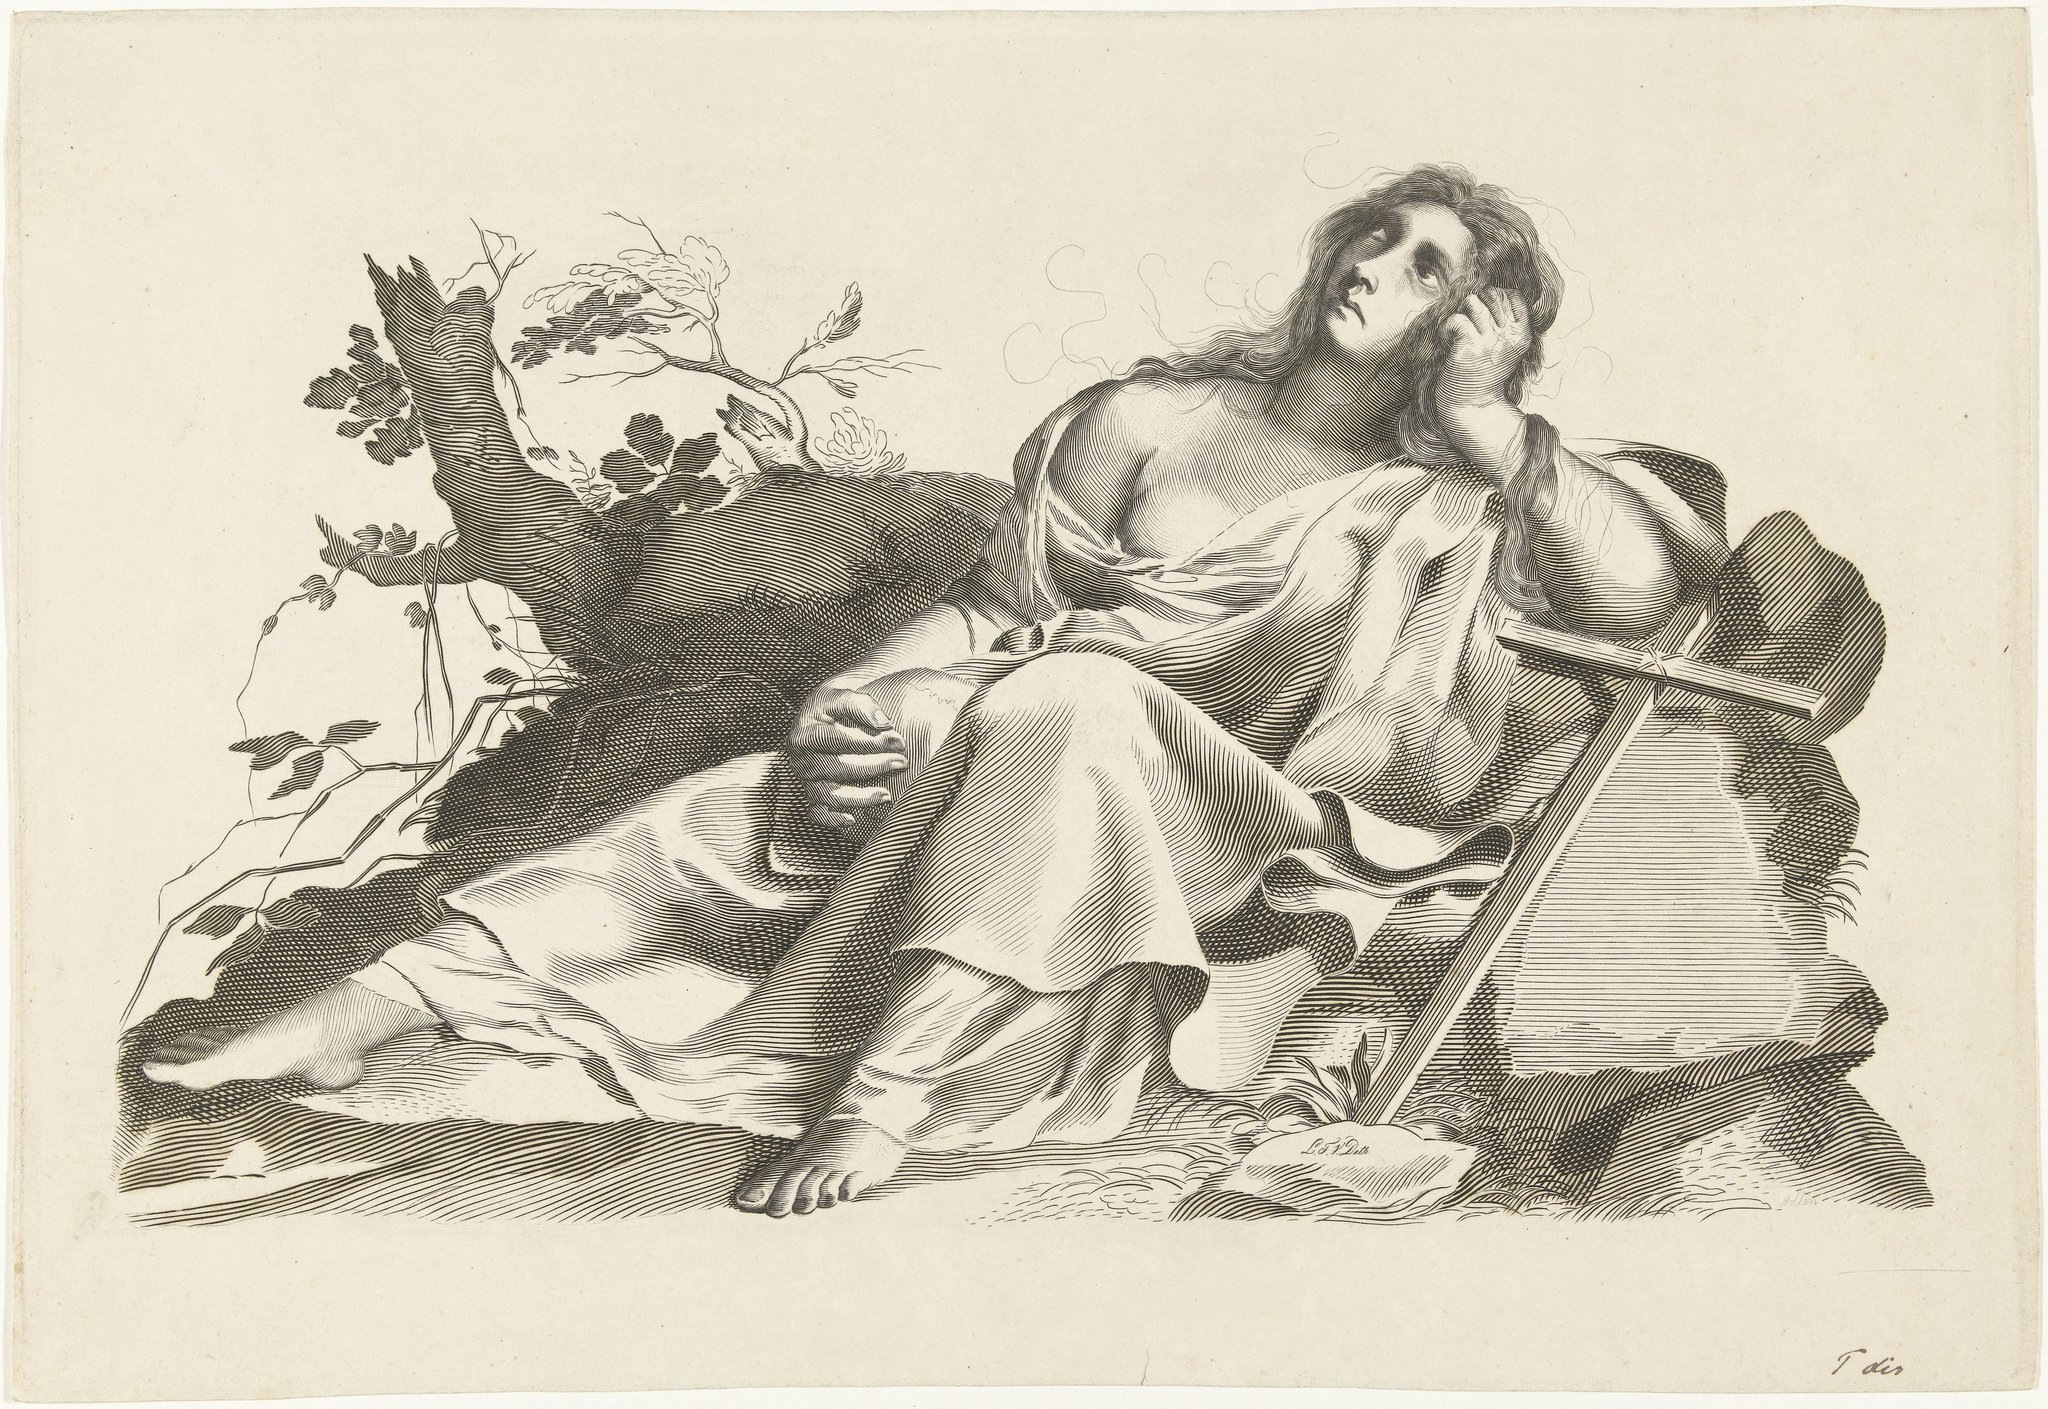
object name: print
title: Personificatie van hoop zittend met kruis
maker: lubertus teunis van deth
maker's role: draughtsman, print maker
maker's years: 1814-1875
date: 1824-1875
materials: paper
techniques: engraving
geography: netherlands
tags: hope, 'spes'; 'speranza divina e certa' (ripa) ~ one of the three theological virtues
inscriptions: collector's mark: Lugt 2228